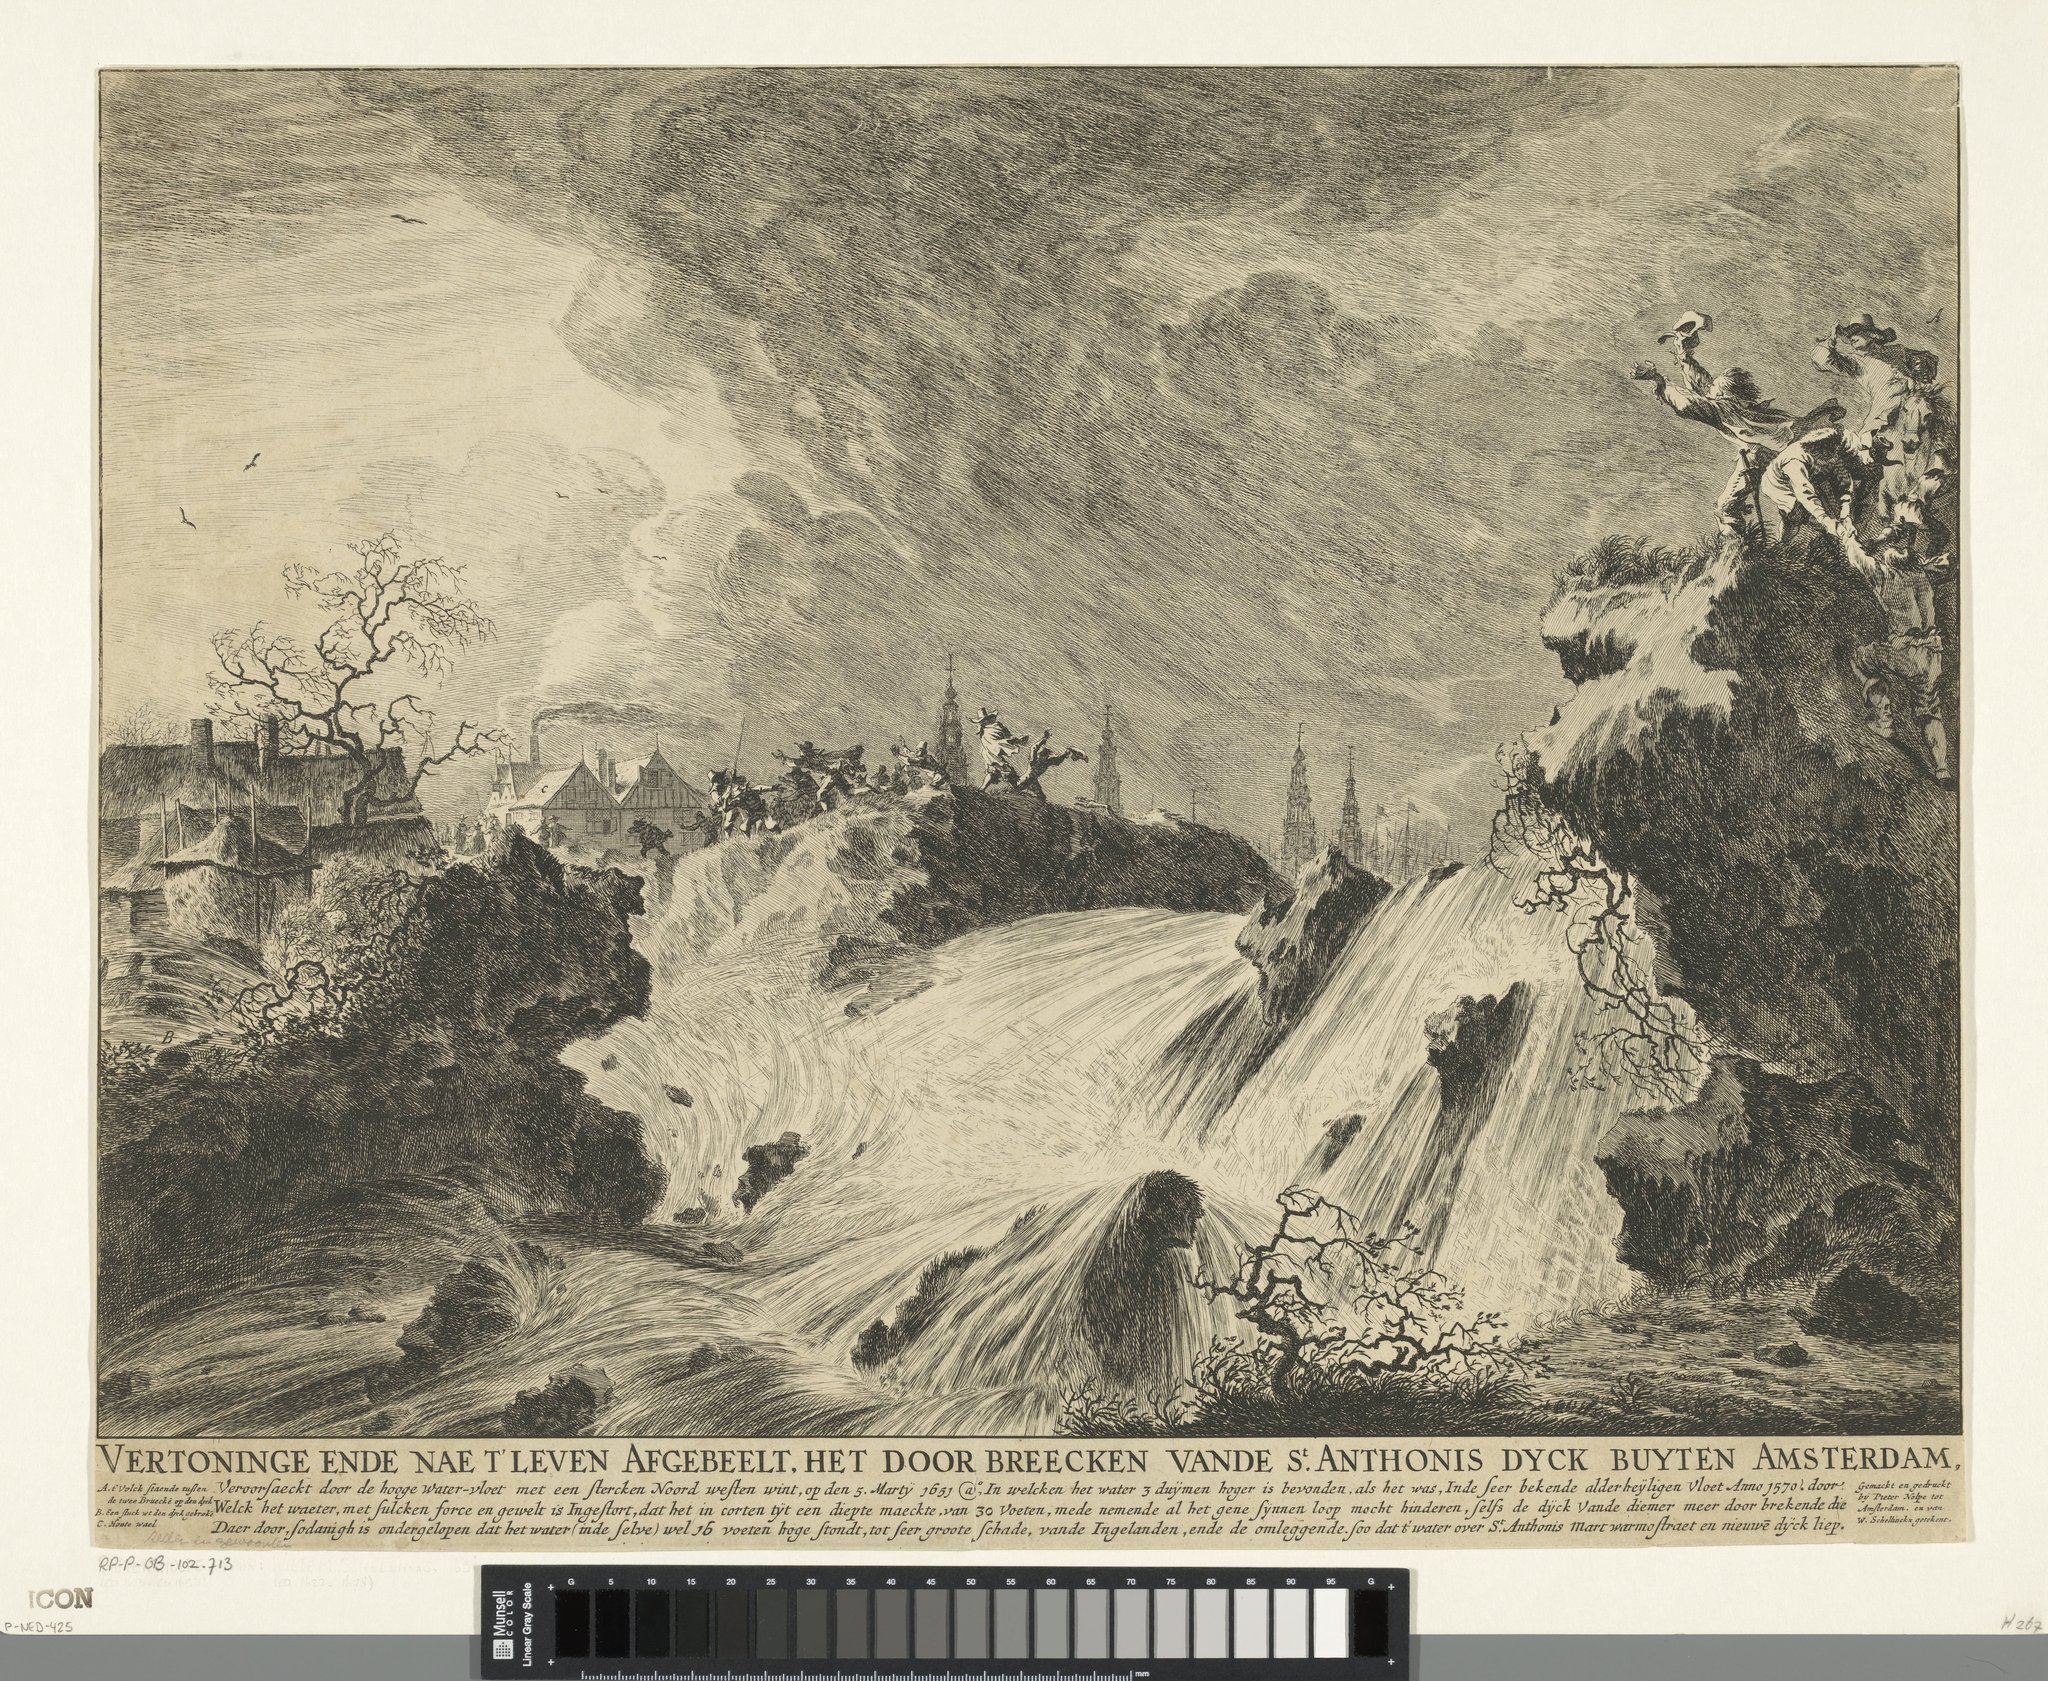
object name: print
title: Doorbraak van de Sint-Antoniesdijk op 5 maart 1651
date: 1651-1653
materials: paper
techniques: engraving, etching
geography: amsterdam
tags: dike-break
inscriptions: collector's mark: Lugt 2228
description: Dijkdoorbraak van de Sint-Antoniesdijk of Diemerzeedijk buiten Amsterdam op 5 maart 1651, veroorzaakt door de hoge watervloed en de sterke noordwester storm. Het water stroomt door het gat in de dijk, aan weerszijden van het gat toeschouwers in paniek. Op de achtergrond de torens van Amsterdam. Linksonder het eerste deel van de legenda A-C. Zie de bijbehorende plaat (FMH 2020).